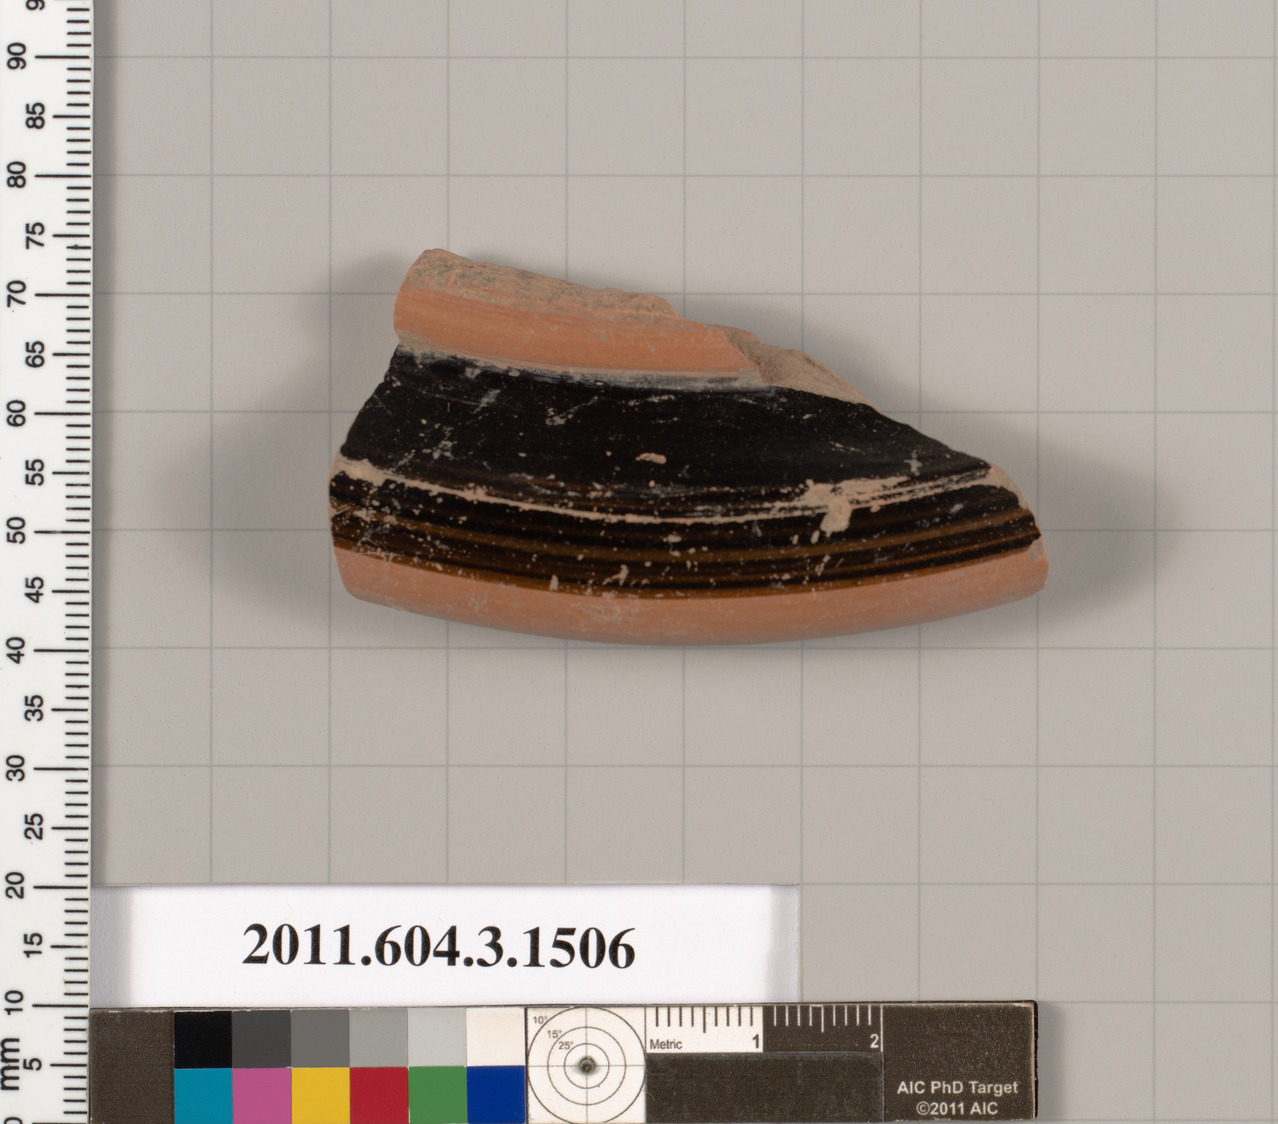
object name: skyphos fragment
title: Terracotta fragment of a skyphos (deep drinking cup)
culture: greek, attic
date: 600-401 BCE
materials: terracotta